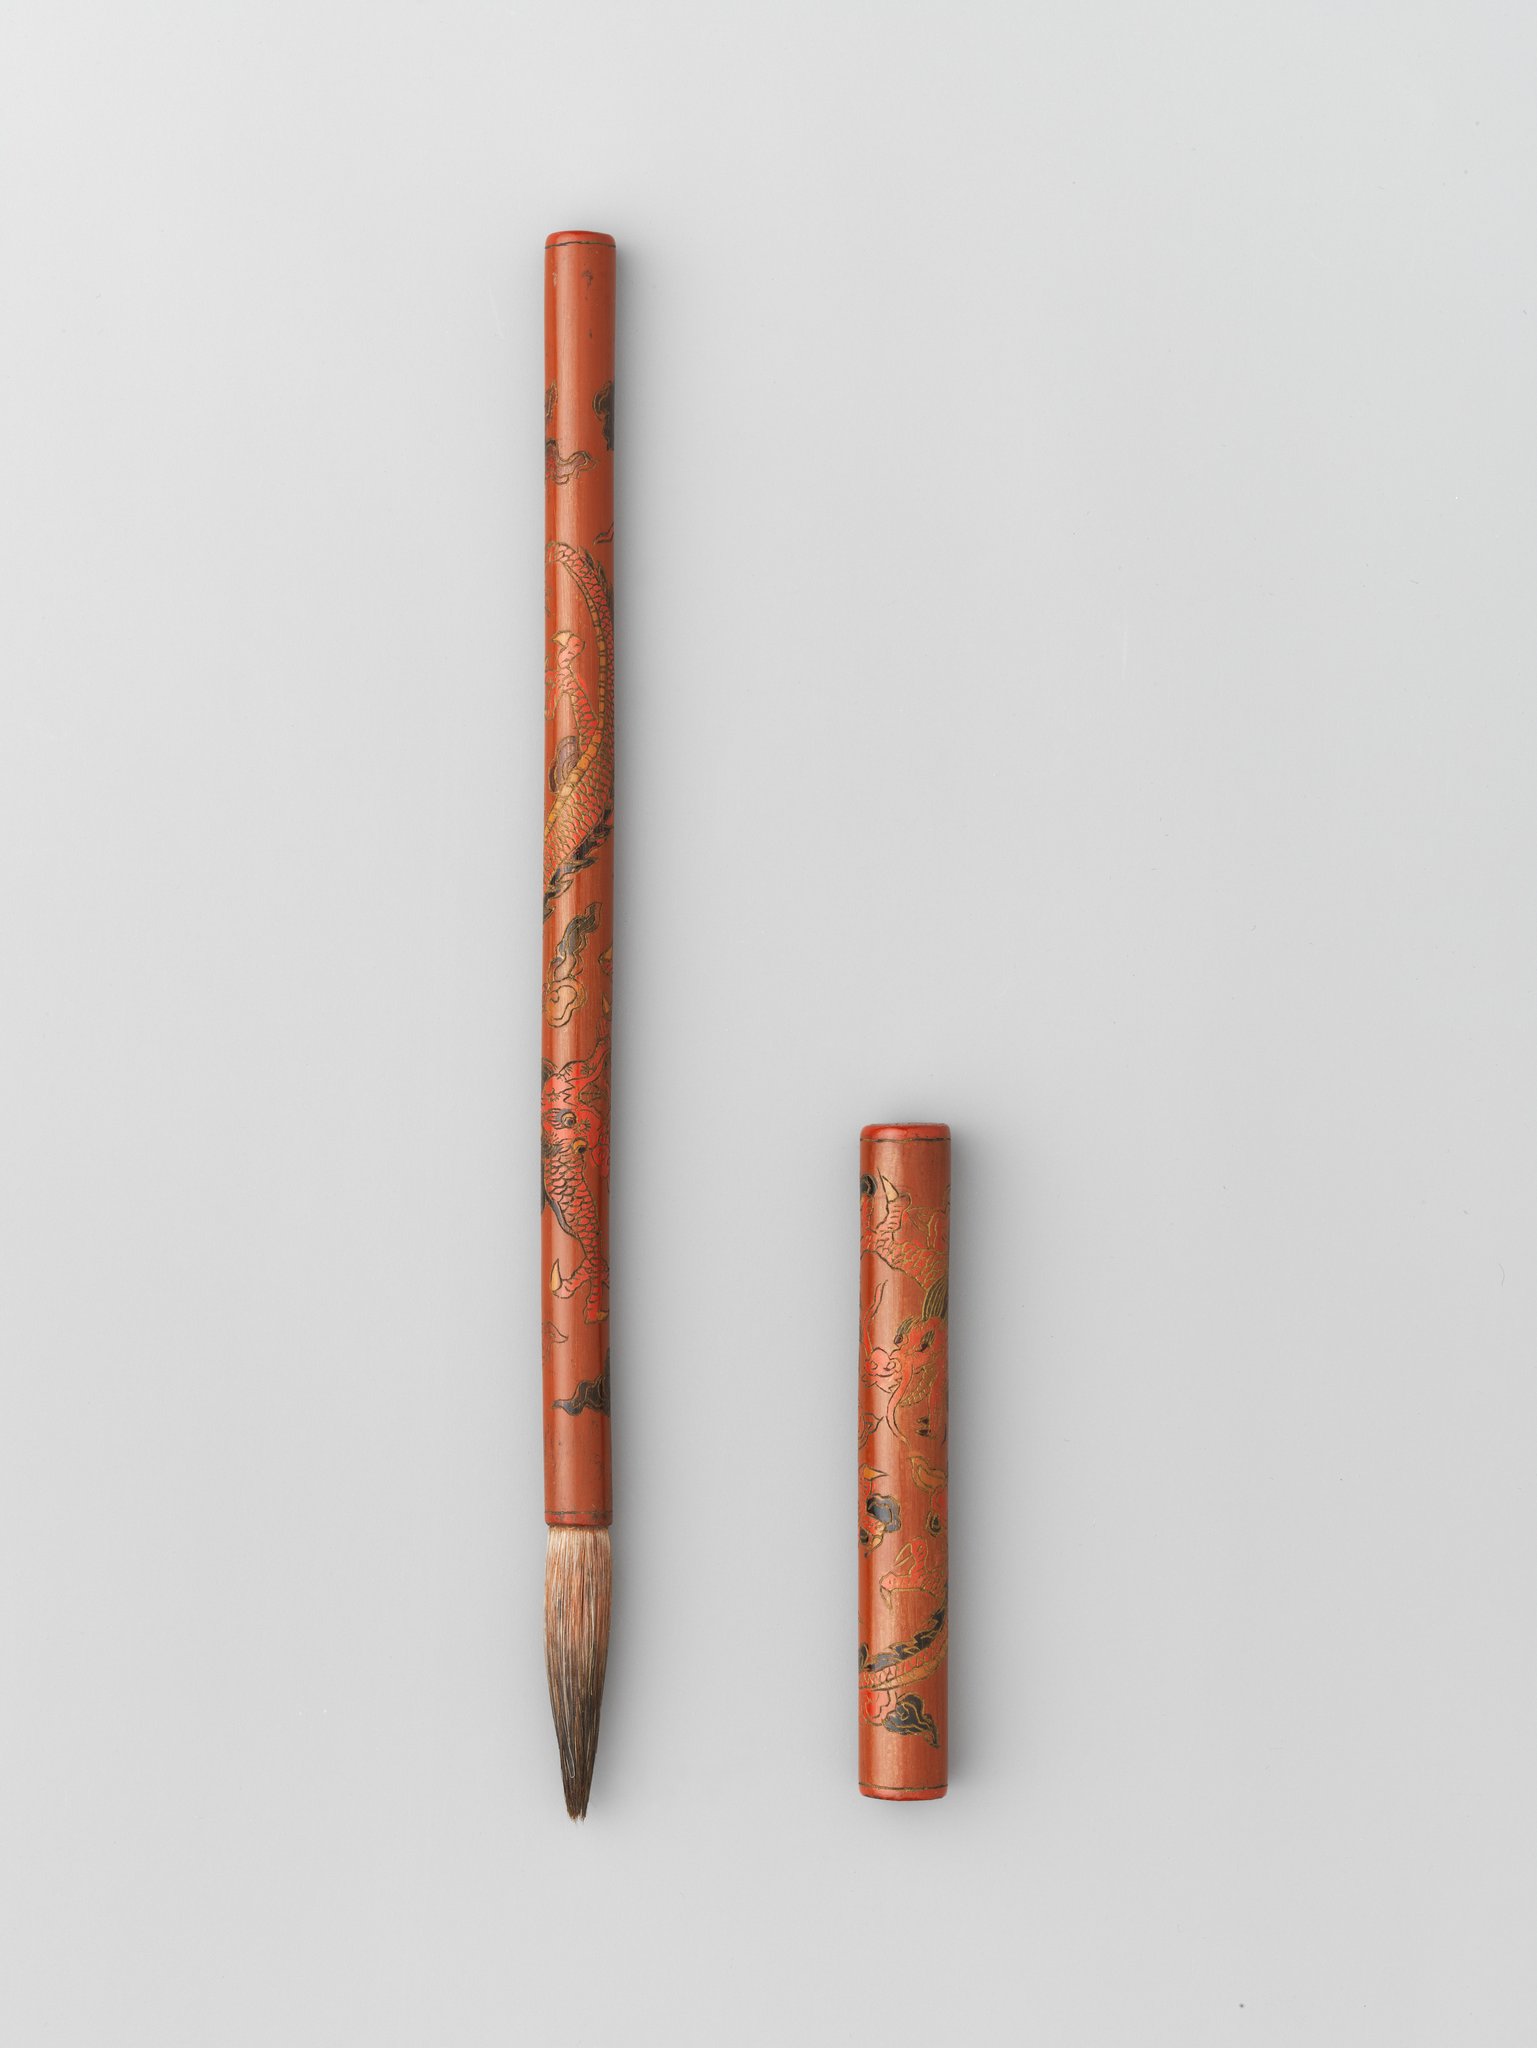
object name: brush and cover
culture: chinese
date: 1573-1620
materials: gold, lacquer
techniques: carving, painting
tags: dragons